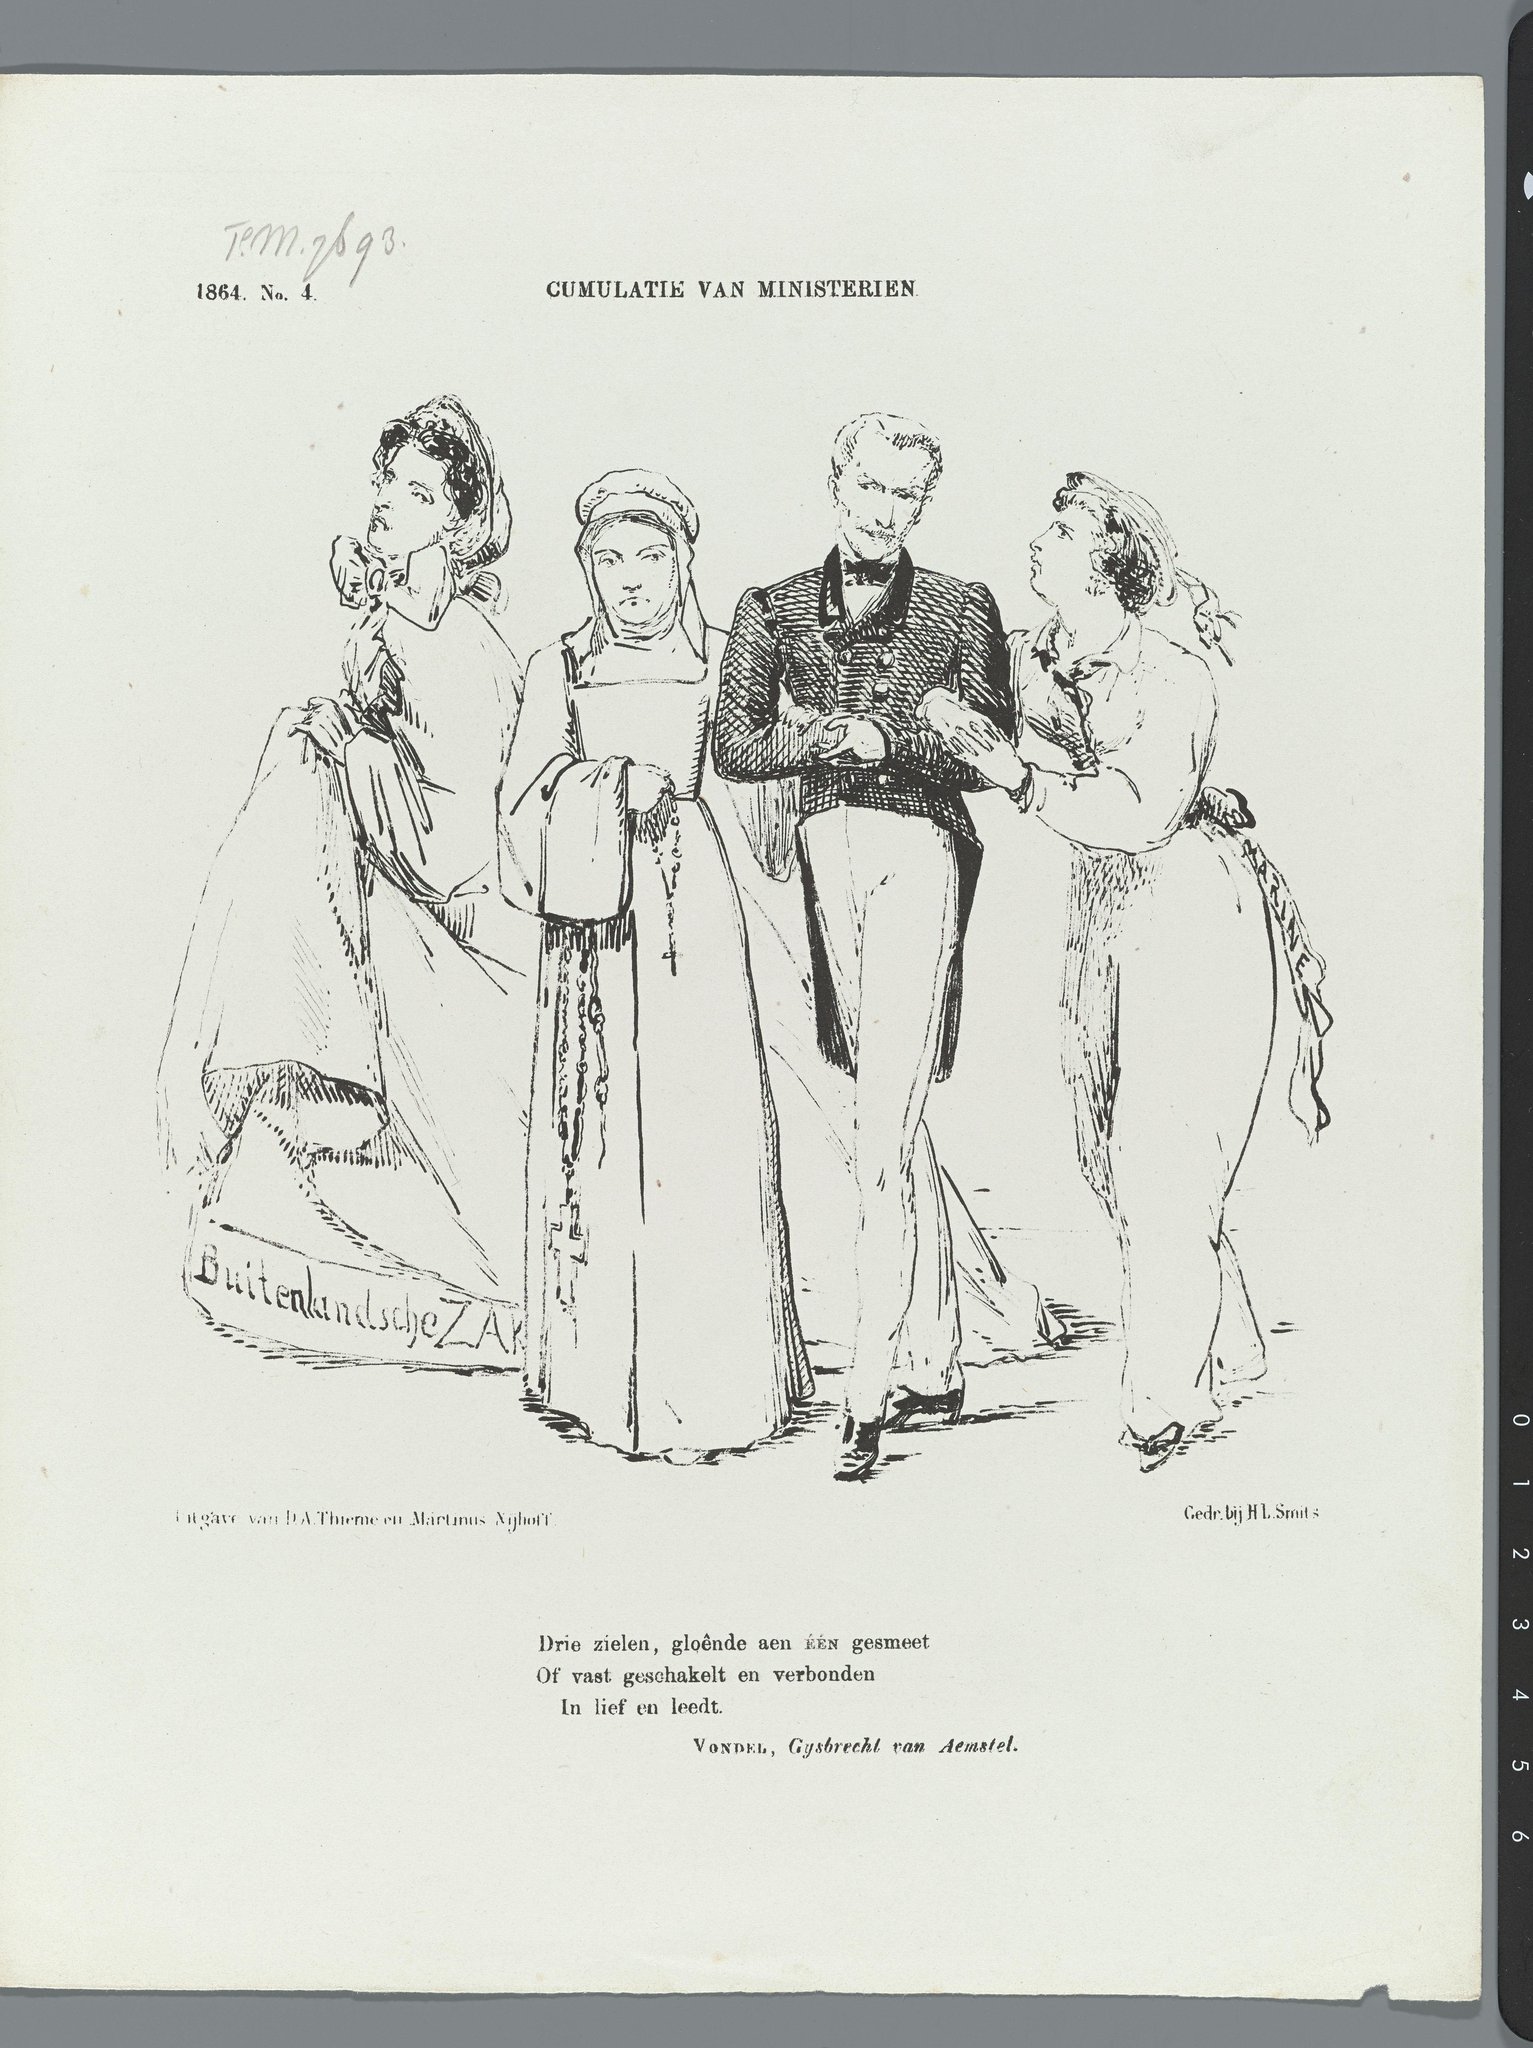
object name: cartoon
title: Cumulatie van Ministeries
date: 1864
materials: paper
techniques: lithograph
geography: the hague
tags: department of the navy, minister ~ government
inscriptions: collector's mark: Lugt 2228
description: Spotprent op Minister van Marine W.J.C.. Huyssen van Kattendijke die tijdelijk ook belast werd met de portefeuilles voor Buitenlandse Zaken en Rooms-Katholieke Eredienst. Plaat verschenen bij het weekblad De Nederlandsche Spectator, nr. 4, 23 januari 1864.